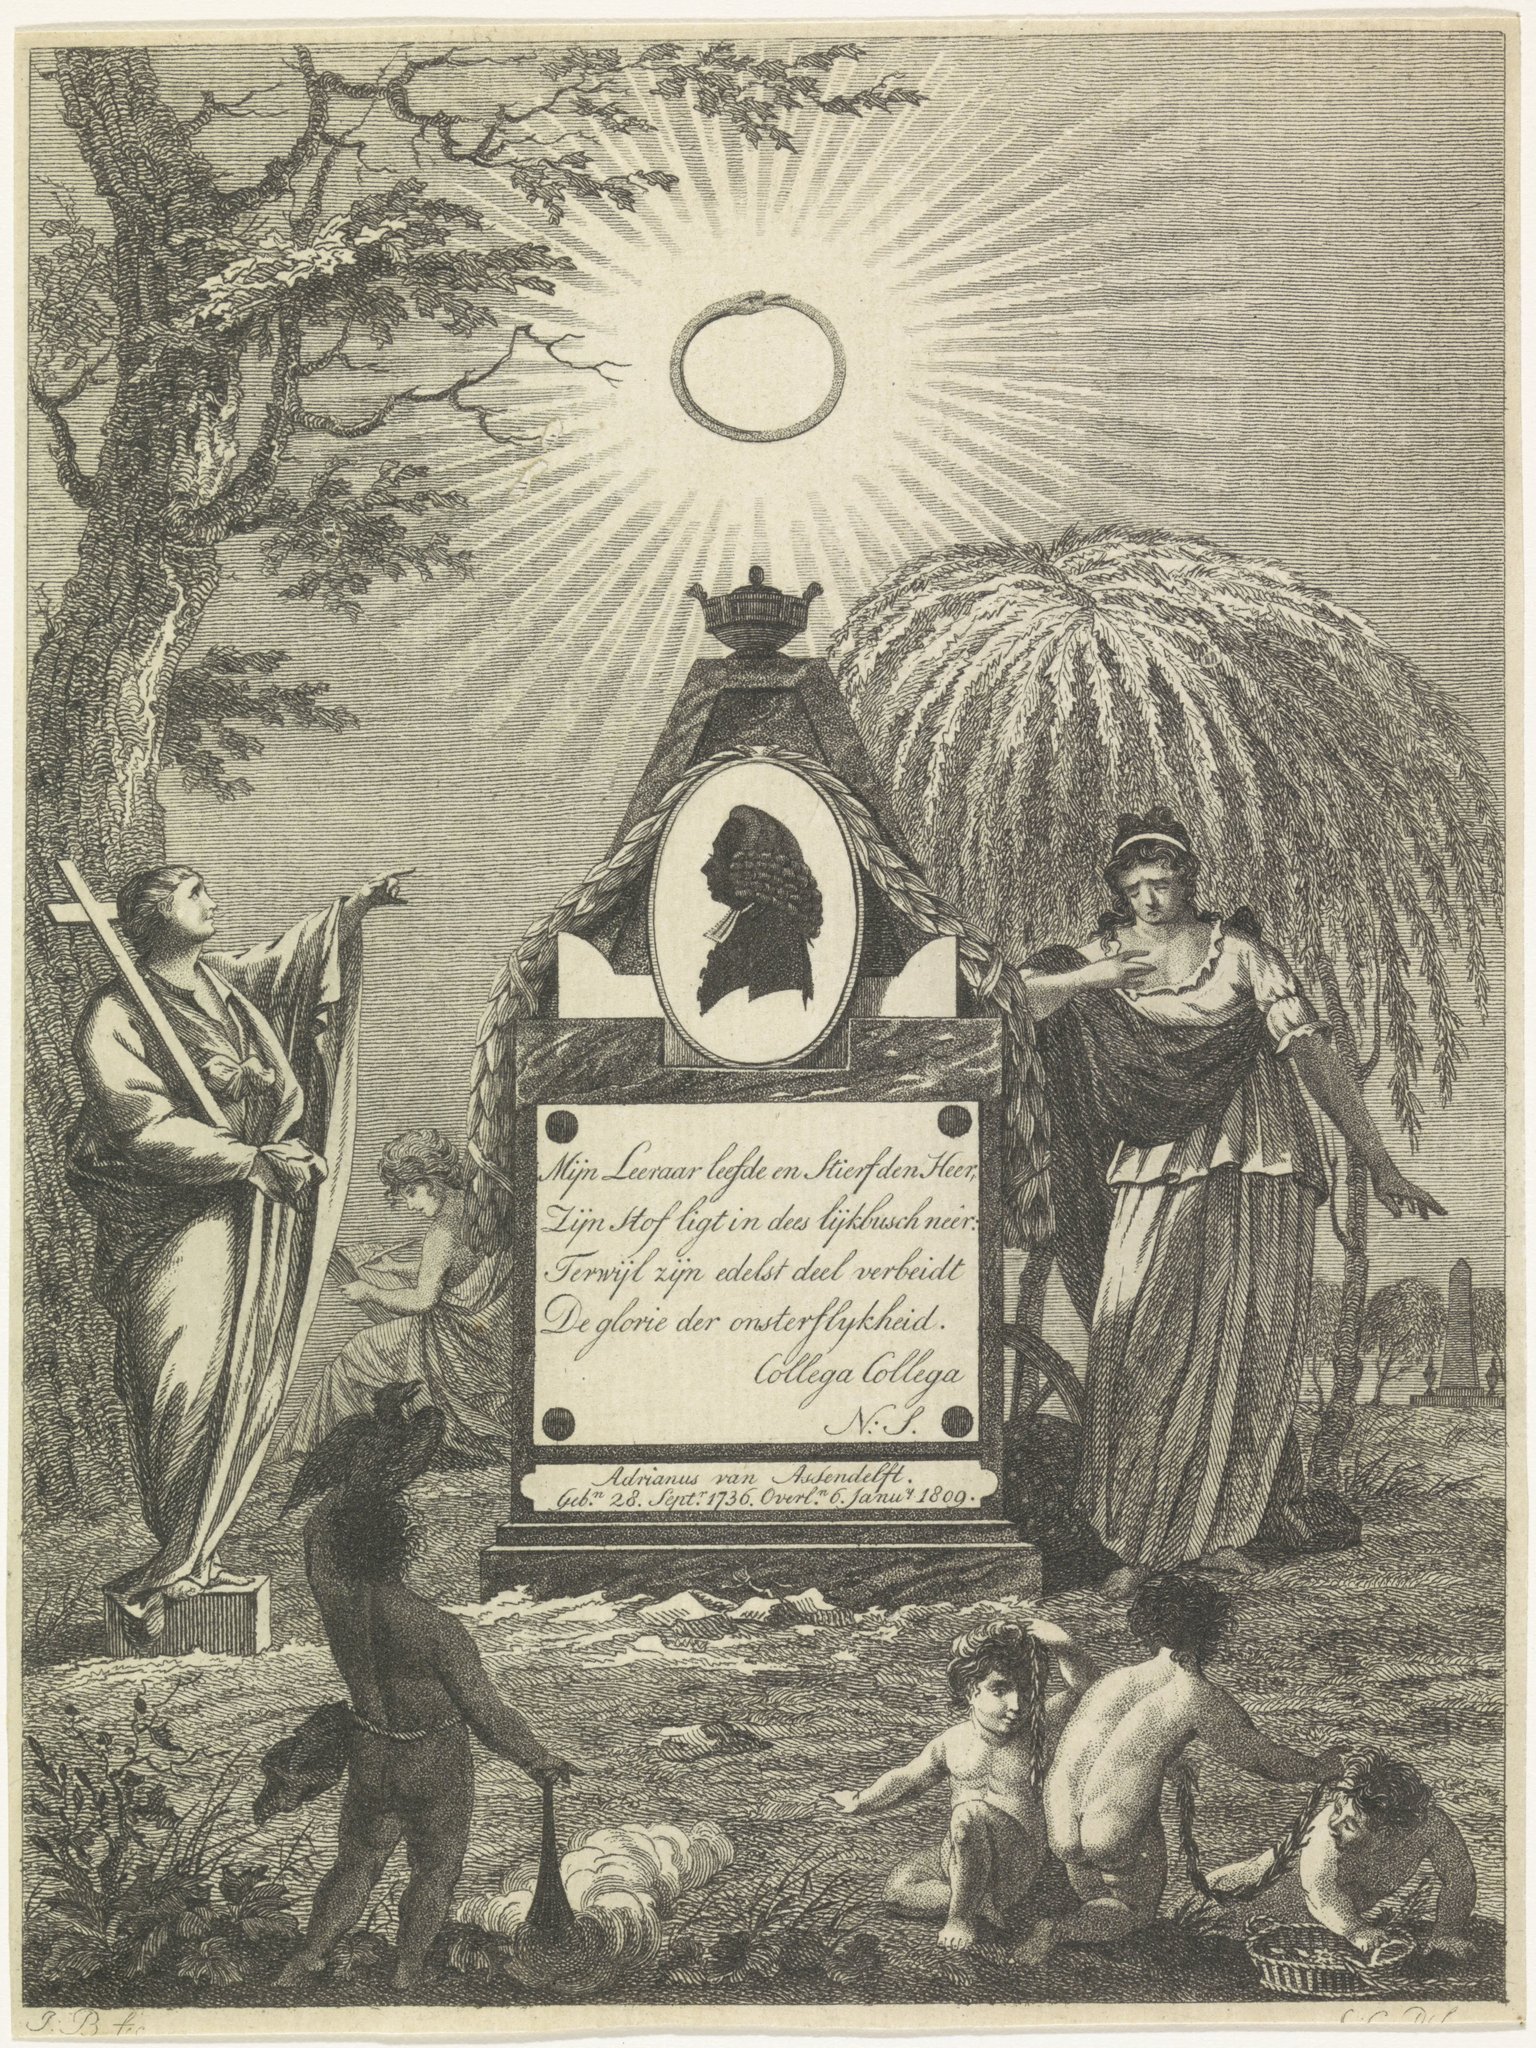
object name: print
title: Gedenkteken voor Adrianus van Assendelft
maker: monogrammist jb (graveur)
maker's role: print maker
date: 1809-1811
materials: paper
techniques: etching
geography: netherlands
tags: haarlem, leiden, adrianus van assendelft, other memorial structures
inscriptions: collector's mark: Lugt 2228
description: Allegorische figuren bij een monument voor predikant Adrianus van Assendelft. Links het Geloof staande met een kruis in de hand en wijzend naar de hemel. Rechts een wenende vrouw. Aan de hemel een slang die in zijn eigen staart bijt als eeuwigheidsymbool. Op de voorgrond putti, waarvan één een gedoofde toorts in de hand houdt. Op het monument het silhouetportret van Adrianus van Assendelft.